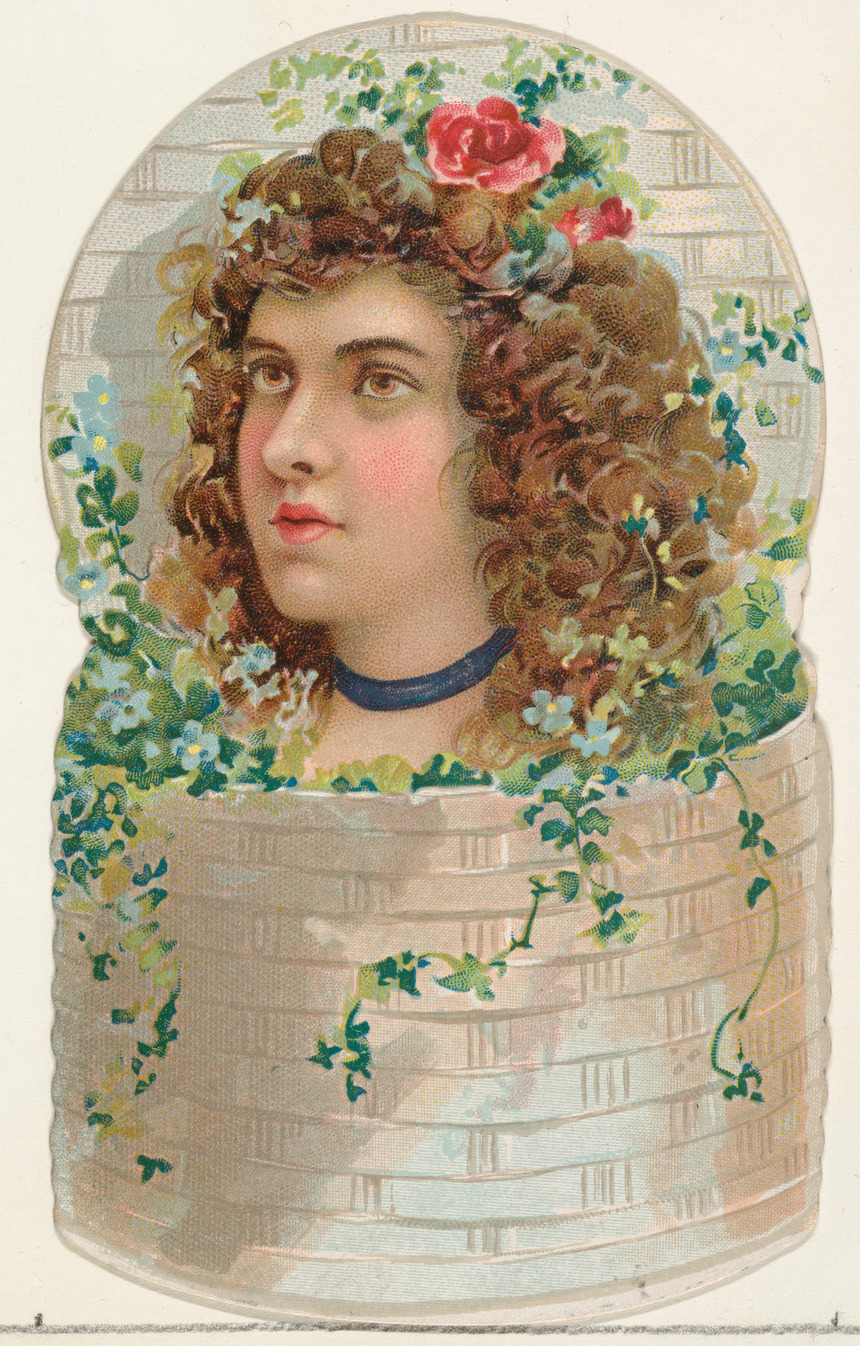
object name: print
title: Wicker Box, from the Novelties series (N122) issued by Gail & Ax Tobacco to promote Navy Long Cut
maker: gail & ax tobacco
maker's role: publisher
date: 1889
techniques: color lithograph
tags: women